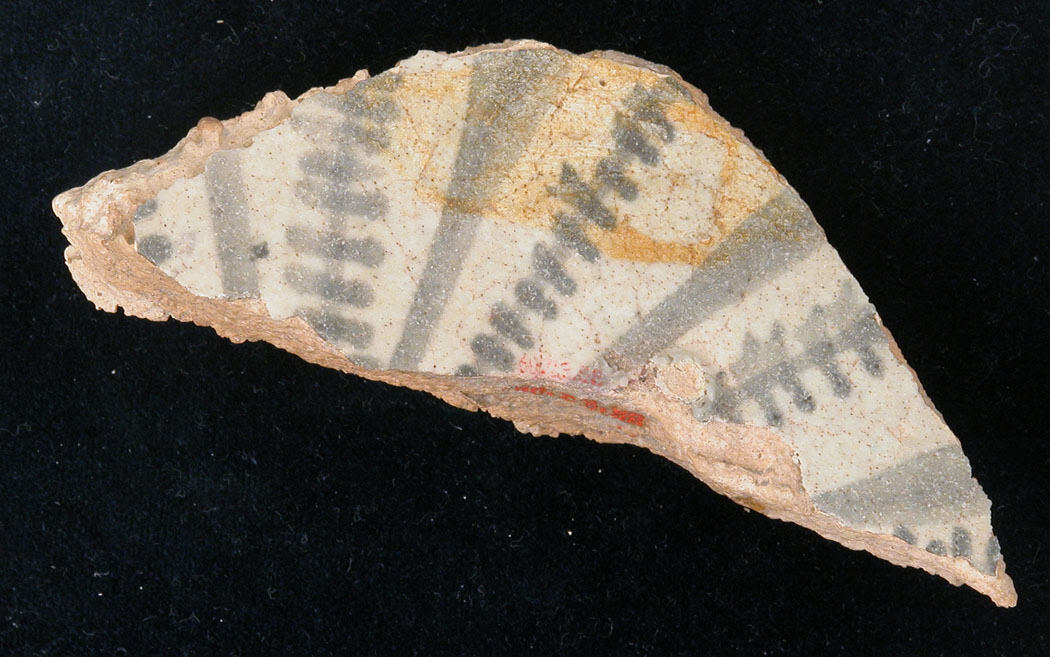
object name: fragment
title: Ceramic Fragment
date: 1201-1600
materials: earthenware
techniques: glazing, painting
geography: saudi arabia